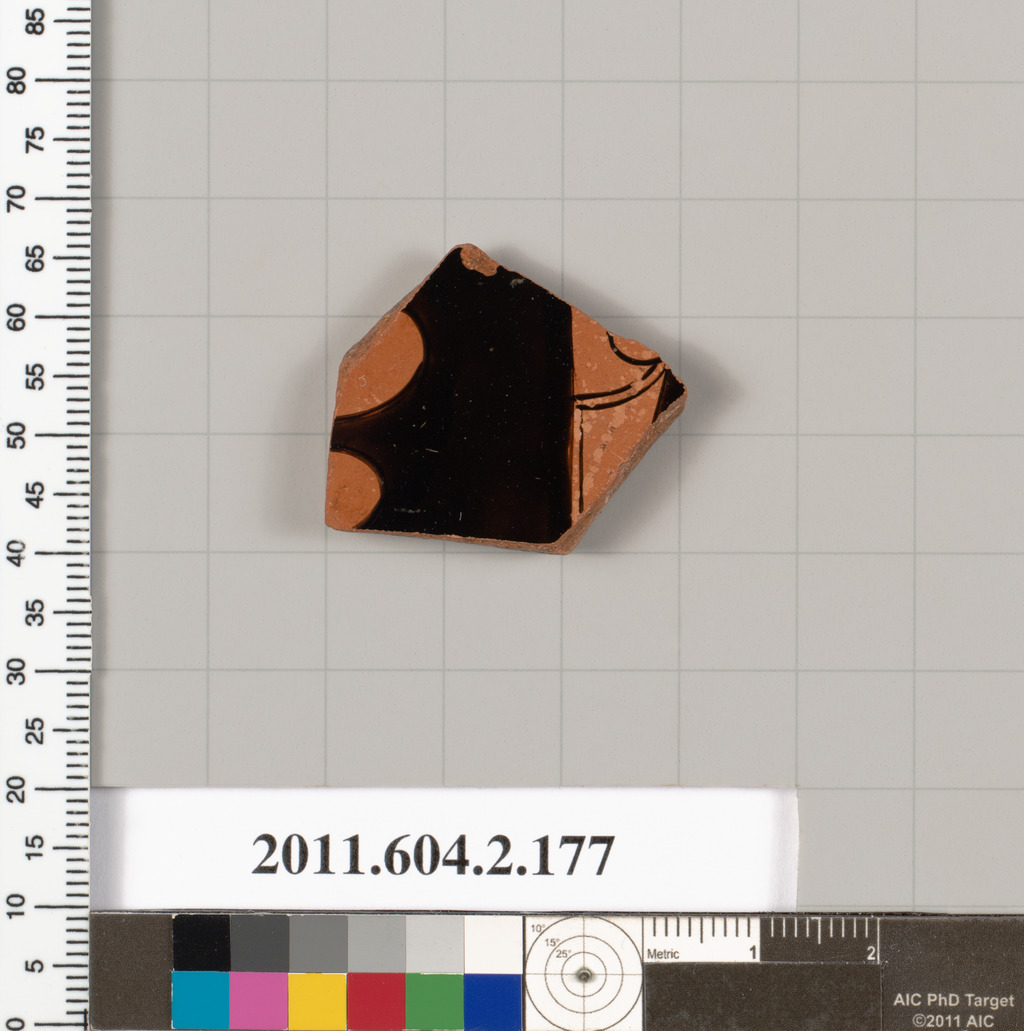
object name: stamnos fragment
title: Terracotta fragment of a stamnos (jar)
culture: greek, attic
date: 500-476 BCE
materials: terracotta